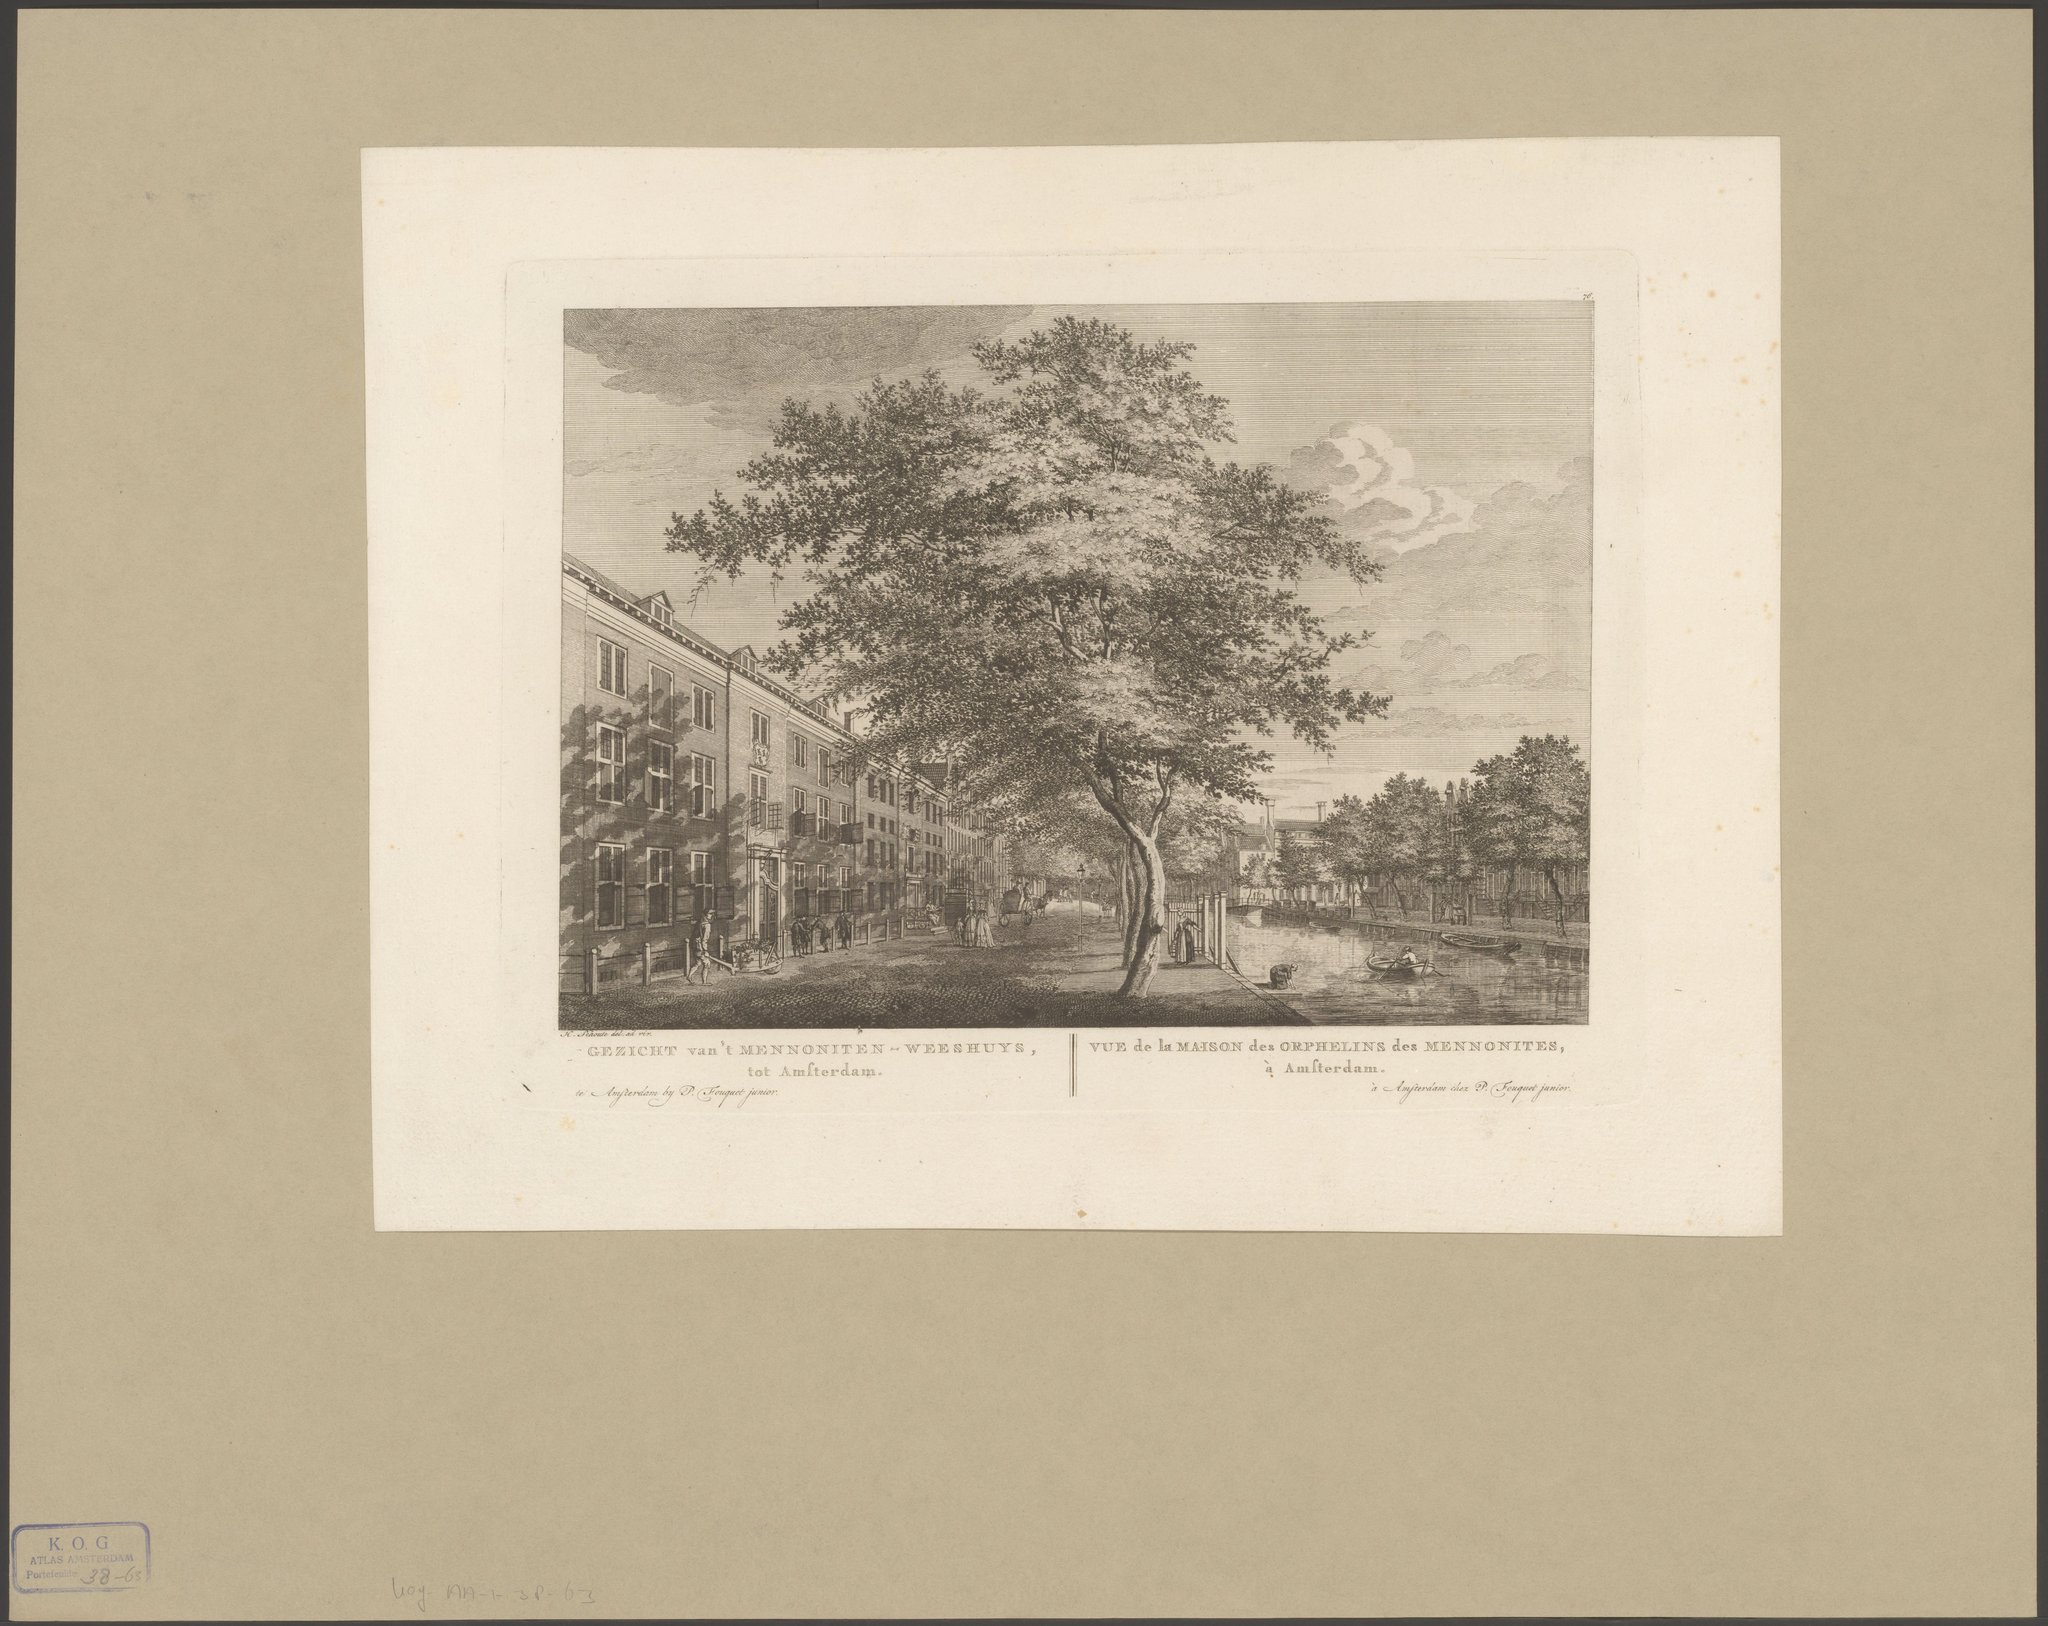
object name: print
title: Gezicht van 't Mennoniten-weeshuys, tot Amsterdam / Vue de la Maison des Orphelins des Mennonites, à Amsterdam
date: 1770-1783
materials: paper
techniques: engraving, etching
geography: amsterdam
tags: orphanage, canals, waters (in city) (+ city(-scape) with figures, staffage)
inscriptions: collector's mark: Lugt 1641b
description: Vanaf 1760 gaf Pierre Fouquet stadsgezichten van Amsterdam naar tekeningen van verschillende kunstenaars uit. Deze prenten werden aanvankelijk los verkocht. Later werden ze samengebonden verkocht in verschillende volgordes en aantallen in: (1). Afbeeldingen van de wyd-vermaarde koopstad Amsterdam benevens des zelvs voornaamste gebouwen en gezigten alle naar het leeven getekend / Receuil des edifices les plus considerables et des plus belles vues, de la fameuse ville d'Amsterdam, dessinées d'après nature. Amsterdam: Pierre Fouquet, 1778-1783. Deze 'uitgave' bestond waarschijnlijk alleen uit een titelblad en inhoudsopgave van de tot dusver 100 uitgegeven prenten, die de koper zelf aan zijn of haar reeds verzamelde prenten kon toevoegen. De hoeveelheid en volgorde van prenten verzameld onder deze titel verschilt dus sterk. (2). Nieuwe atlas, van de voornaamste gebouwen en gezigten der stad Amsterdam, met derzelver beknopte beschryvingen. 2 dln. Amsterdam: Daniël Jean Changuion en Petrus den Hengst [in opdracht van Pierre Fouquet], 1783. Ook werden er door verschillende uitgevers tussen 1788 (Amsterdam: Petrus Conradi) en 1805 (Amsterdam: Evert Maaskamp) heruitgaven gepubliceerd.